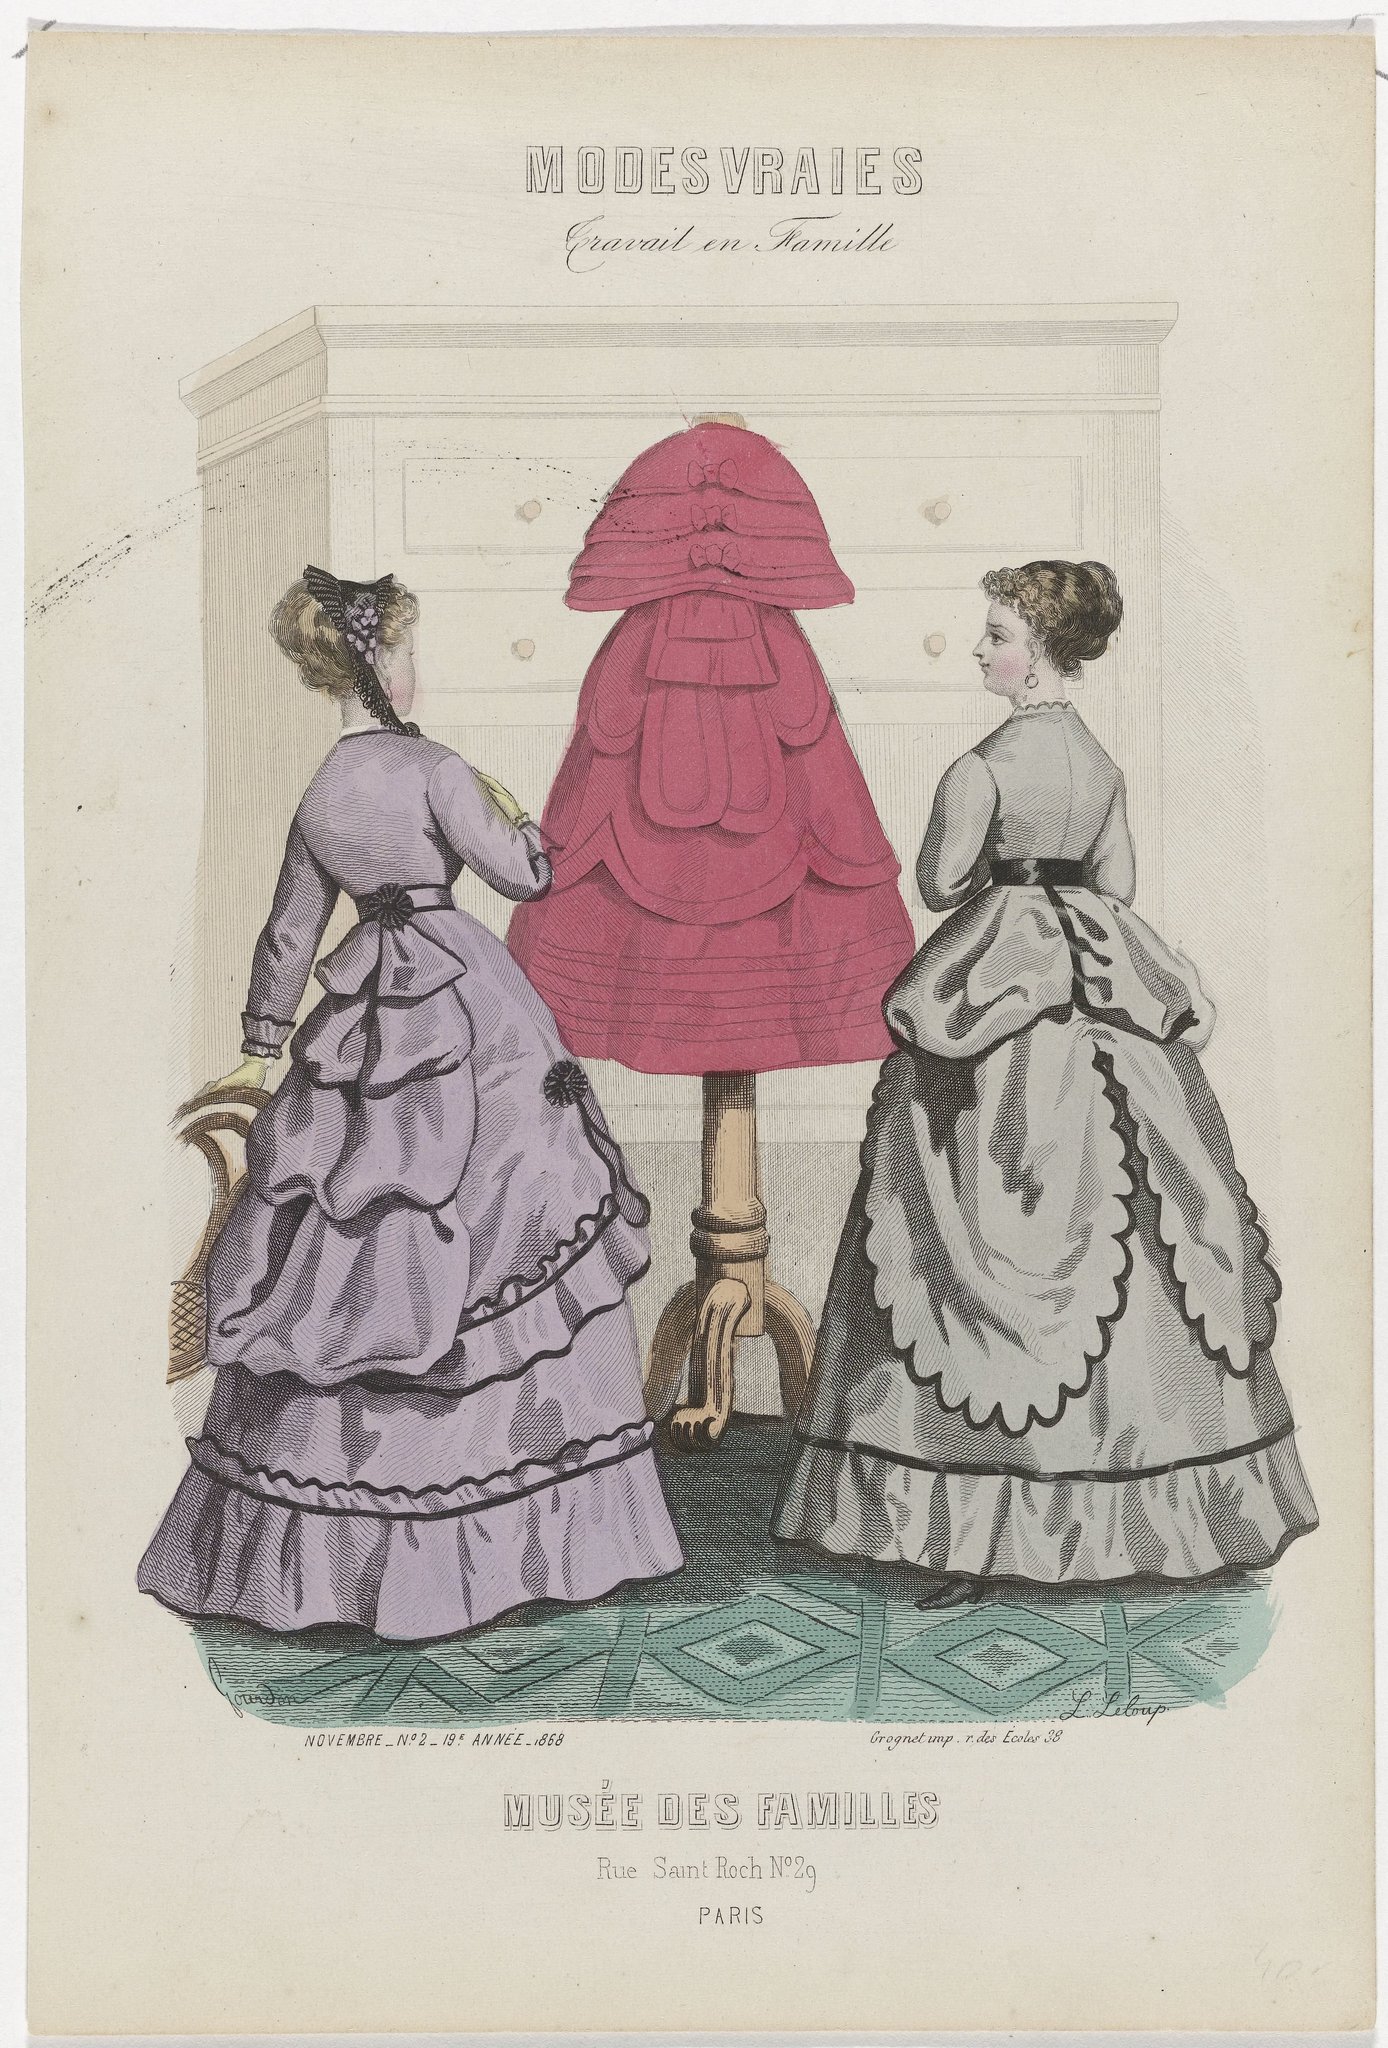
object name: fashion print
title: Musée des Familles, novembre 1868, No. 2, 19e année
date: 1868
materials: paper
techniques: engraving, hand coloring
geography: paris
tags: ear-rings (+ women's clothes), shop-window figures (+ women's clothes), head-gear (+ women's clothes), fashion plates, dress, gown (+ women's clothes), cupboard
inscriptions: title: ‘Musée des Familles’, address: ‘Rue Saint Roch, No. 29 / Paris’, title: ‘Modes Vraies / Travail en Famille’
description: Twee vrouwen, op de rug gezien, kijken naar een model op een paspop. Op de achtergrond een grote ladekast. Links: lichtpaarse japon met middenachter draperingen. Rechts: lichtgrijze japon met geschulpte zoom afgezet met zwarte bies. Prent uit het modetijdschrift Musée des Familles (1833-1874).